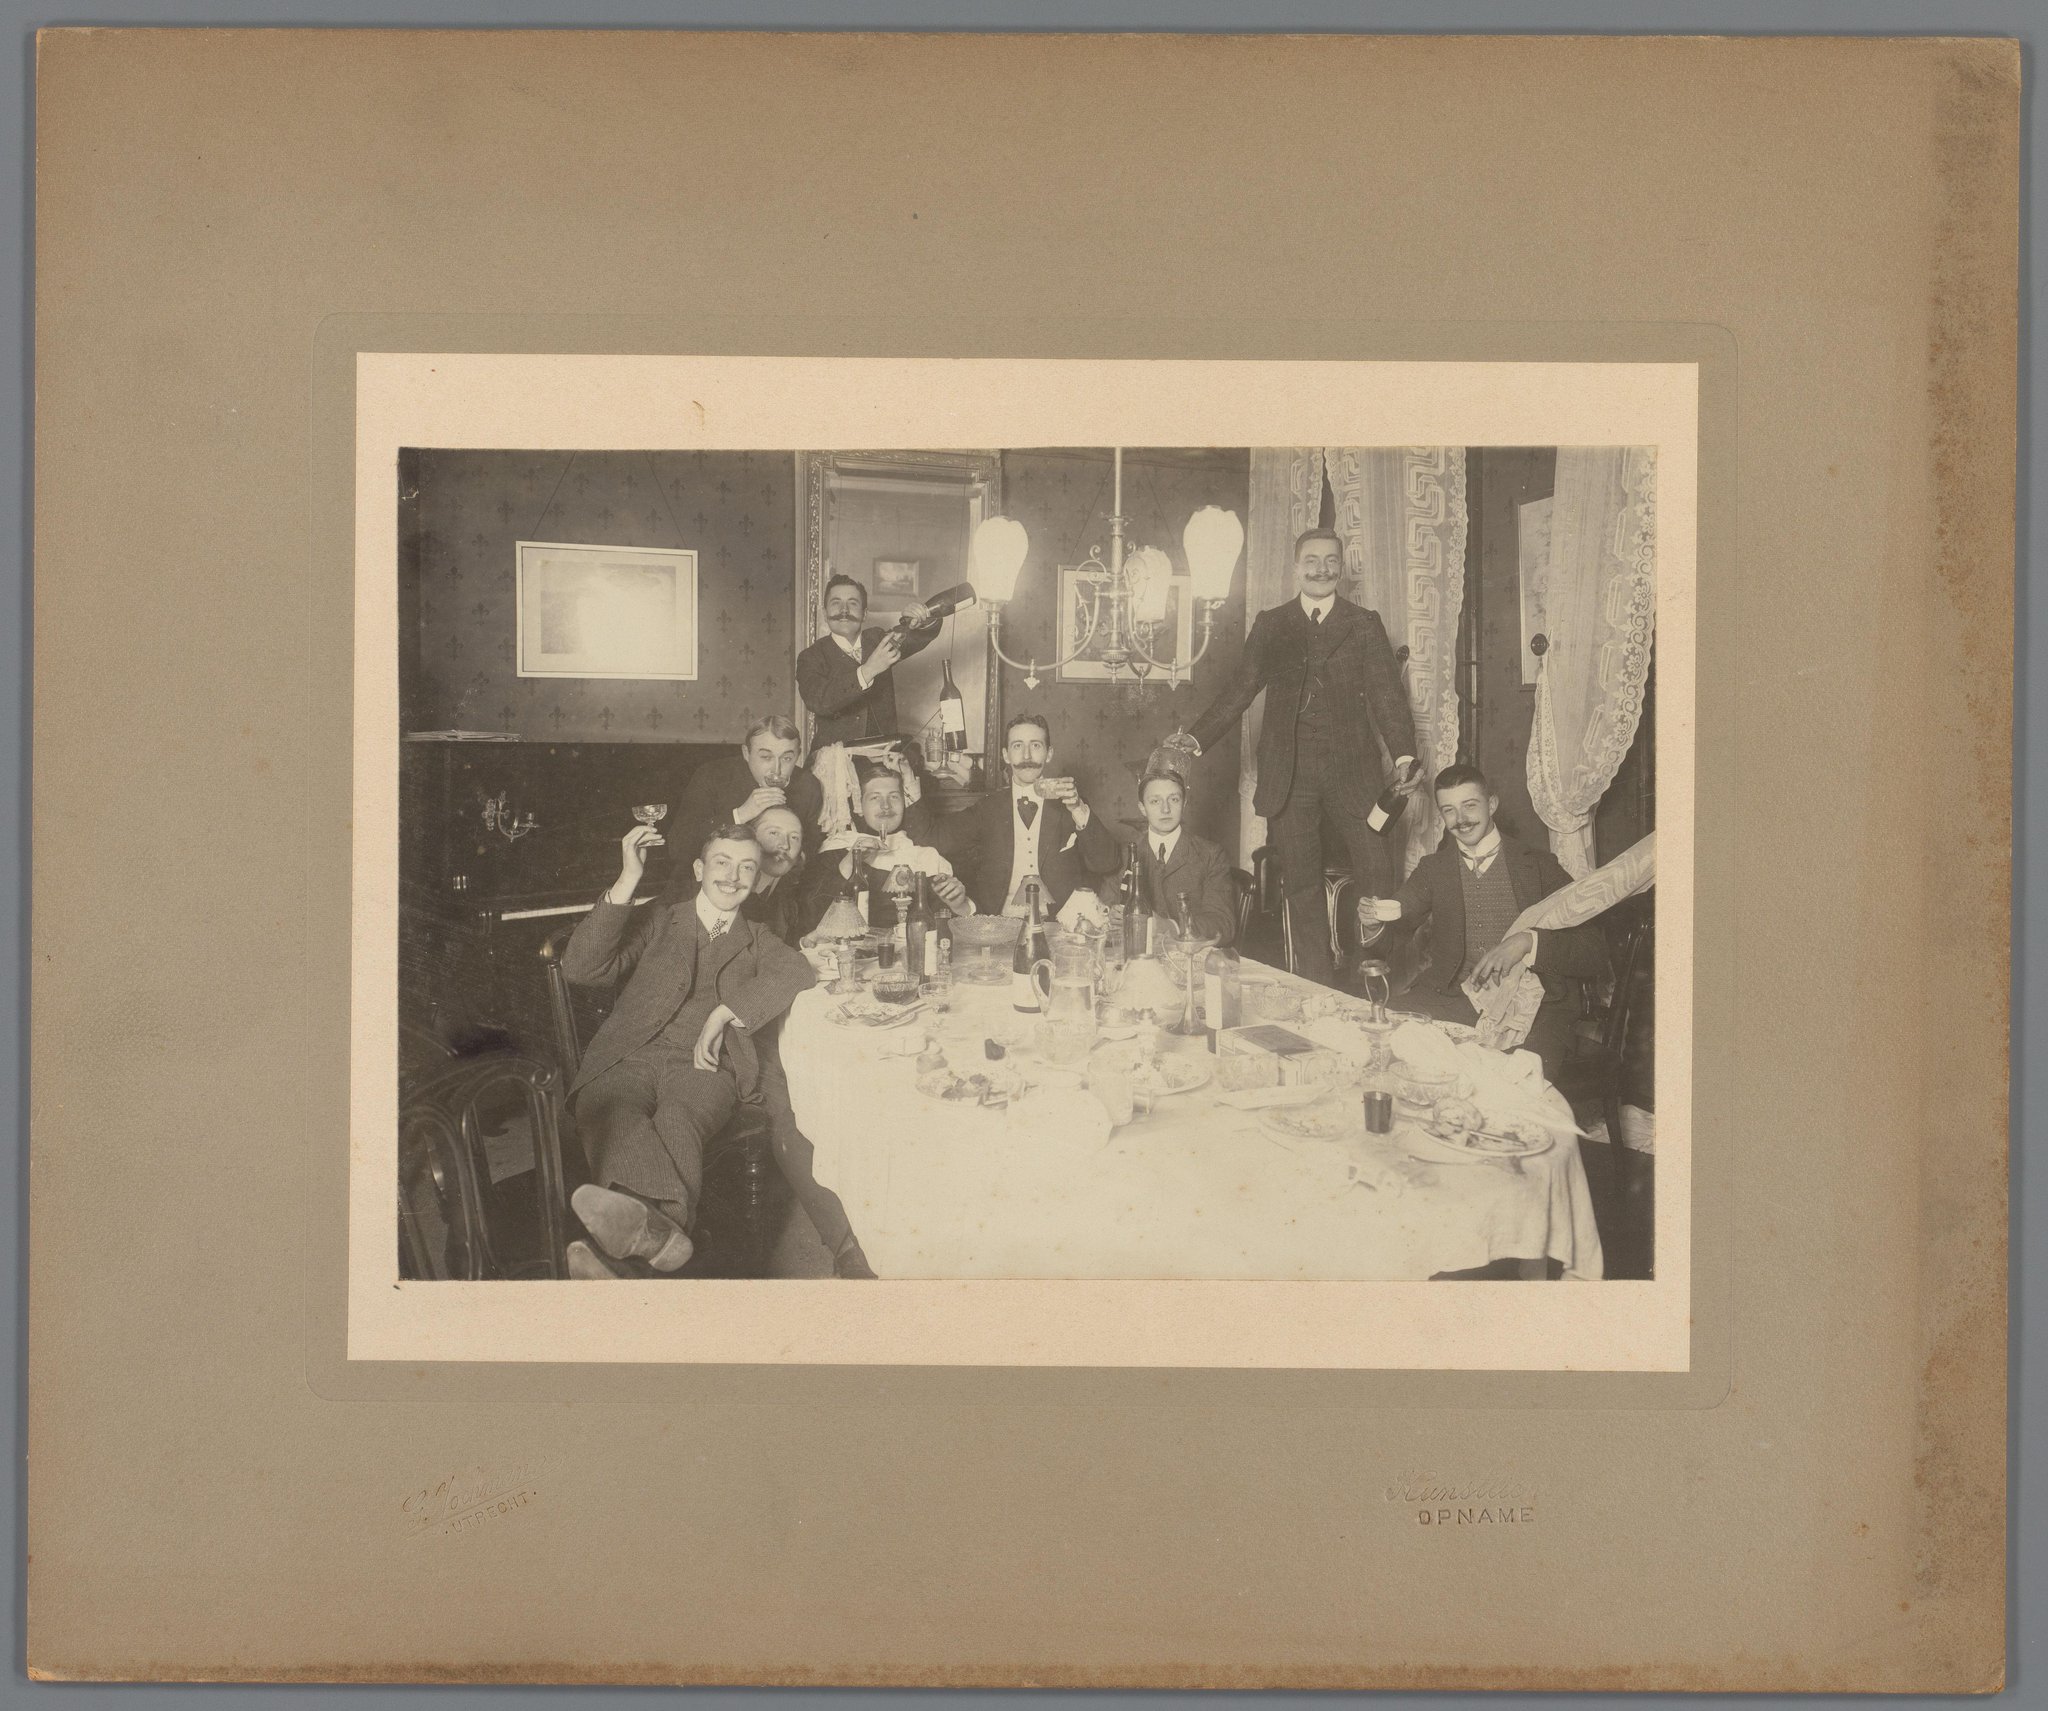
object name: photograph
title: Groepsportret van negen onbekende jongemannen, waarschijnlijk studenten, aan een gedekte tafel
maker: gustav johan erik jochmann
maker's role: fotograaf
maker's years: 1865-1941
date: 1895-1927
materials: paper, cardboard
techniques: gelatin silver print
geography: utrecht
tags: fraternity (students), laid table: table-ware, table-decoration, etc., anonymous historical persons portrayed in a group, in a group-portrait, utrecht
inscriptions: check stamp: ‘Kunstlicht/ Opname’